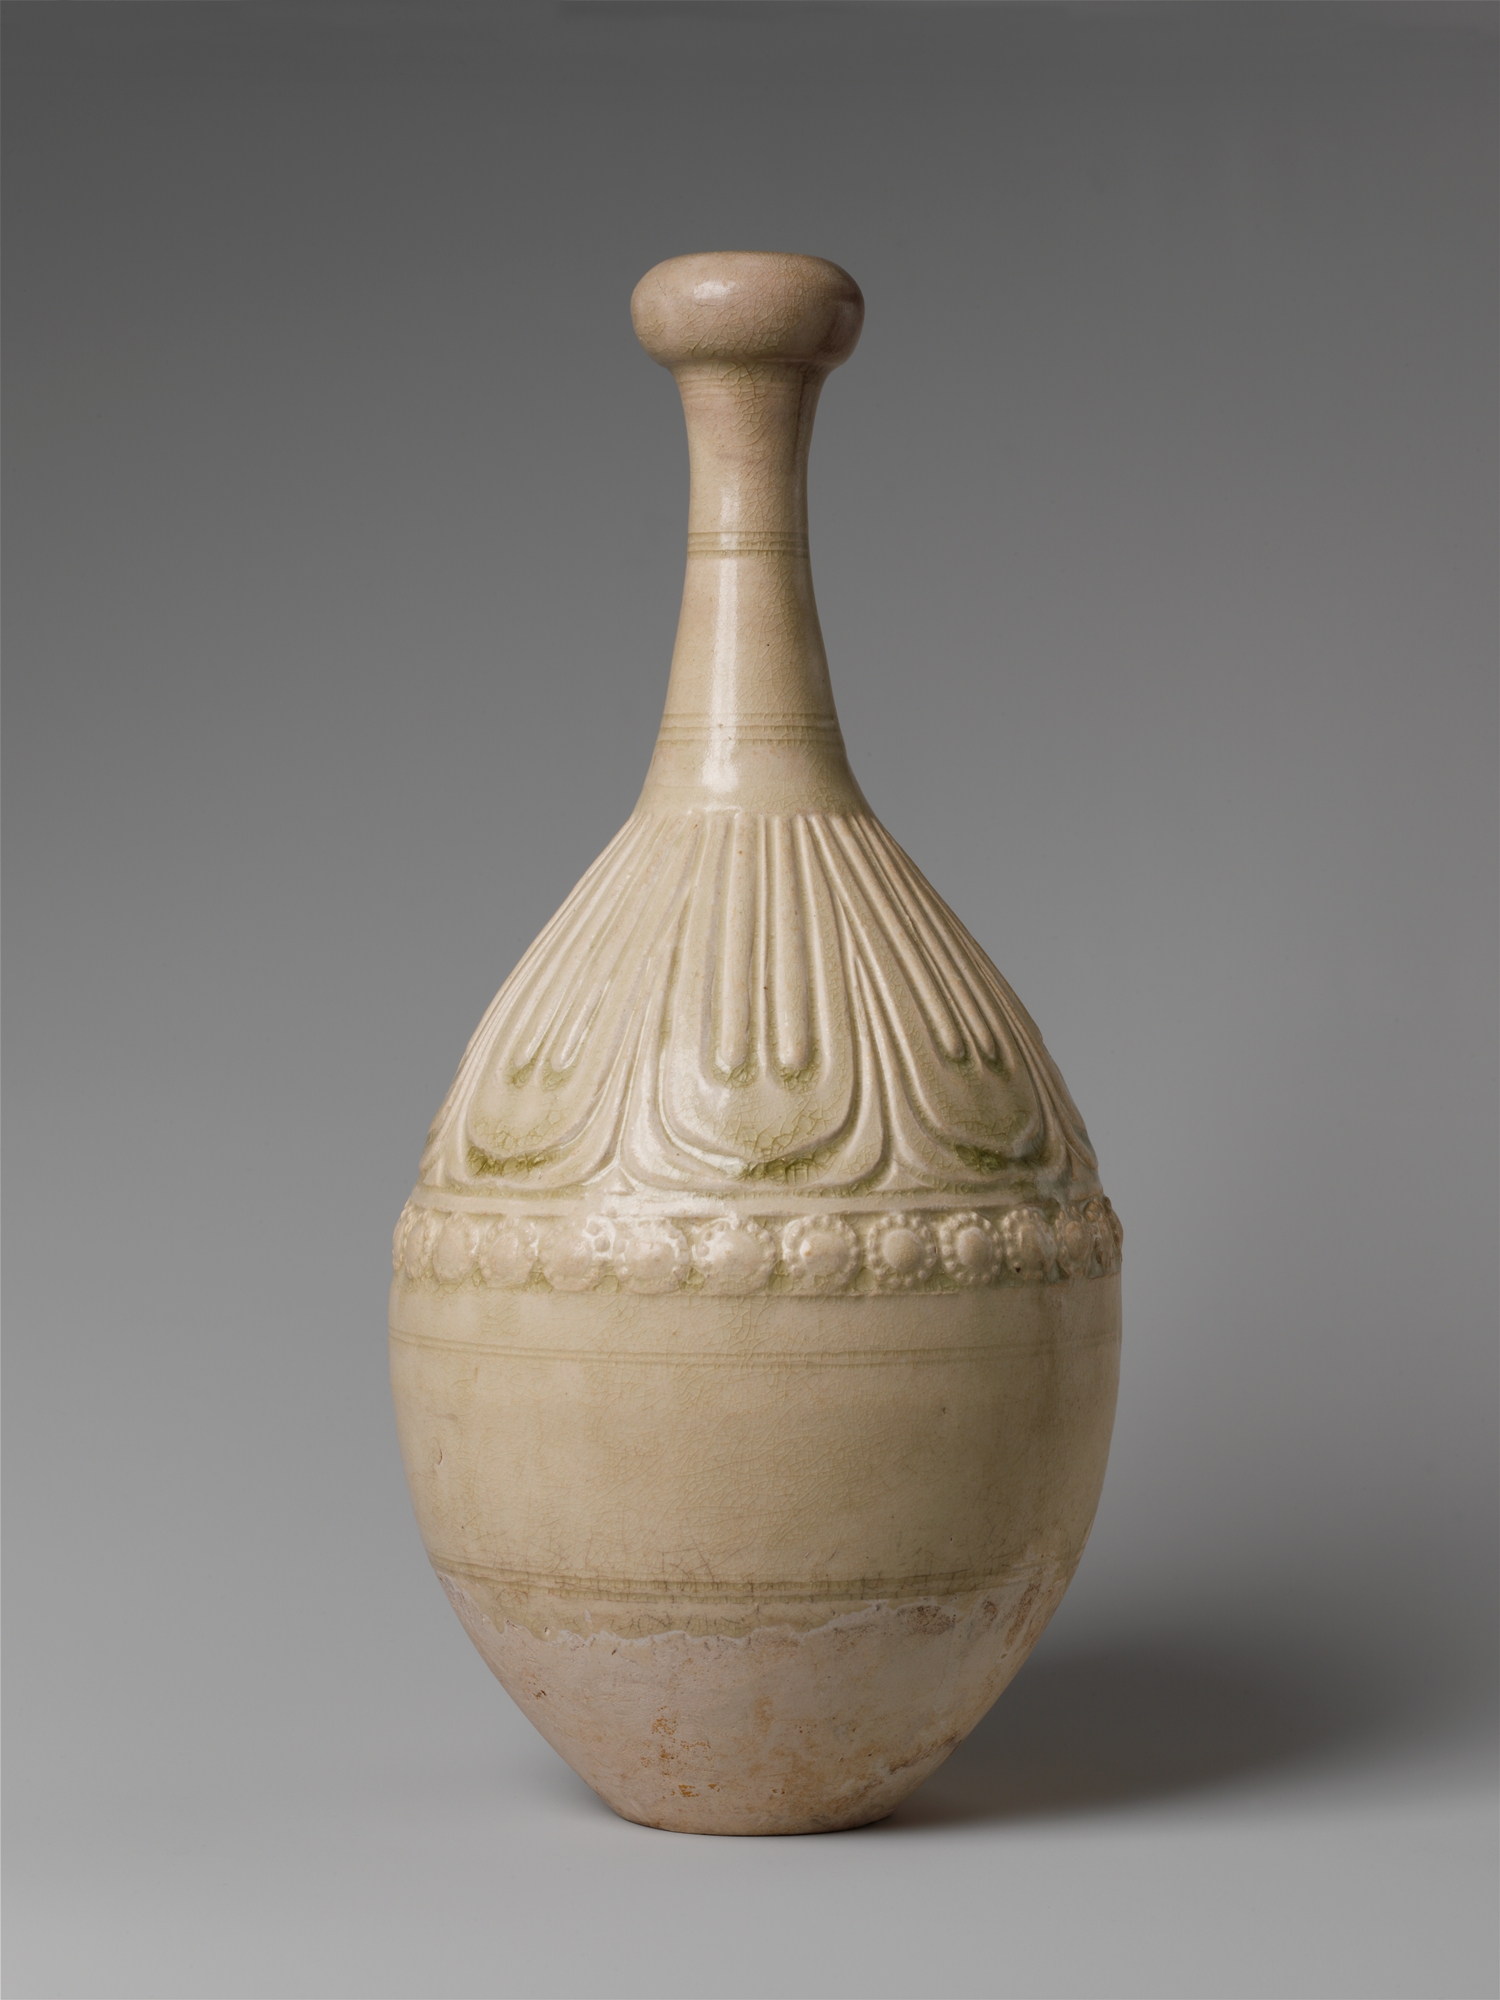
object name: bottle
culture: chinese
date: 501-700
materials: stoneware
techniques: carving, glazing, relief